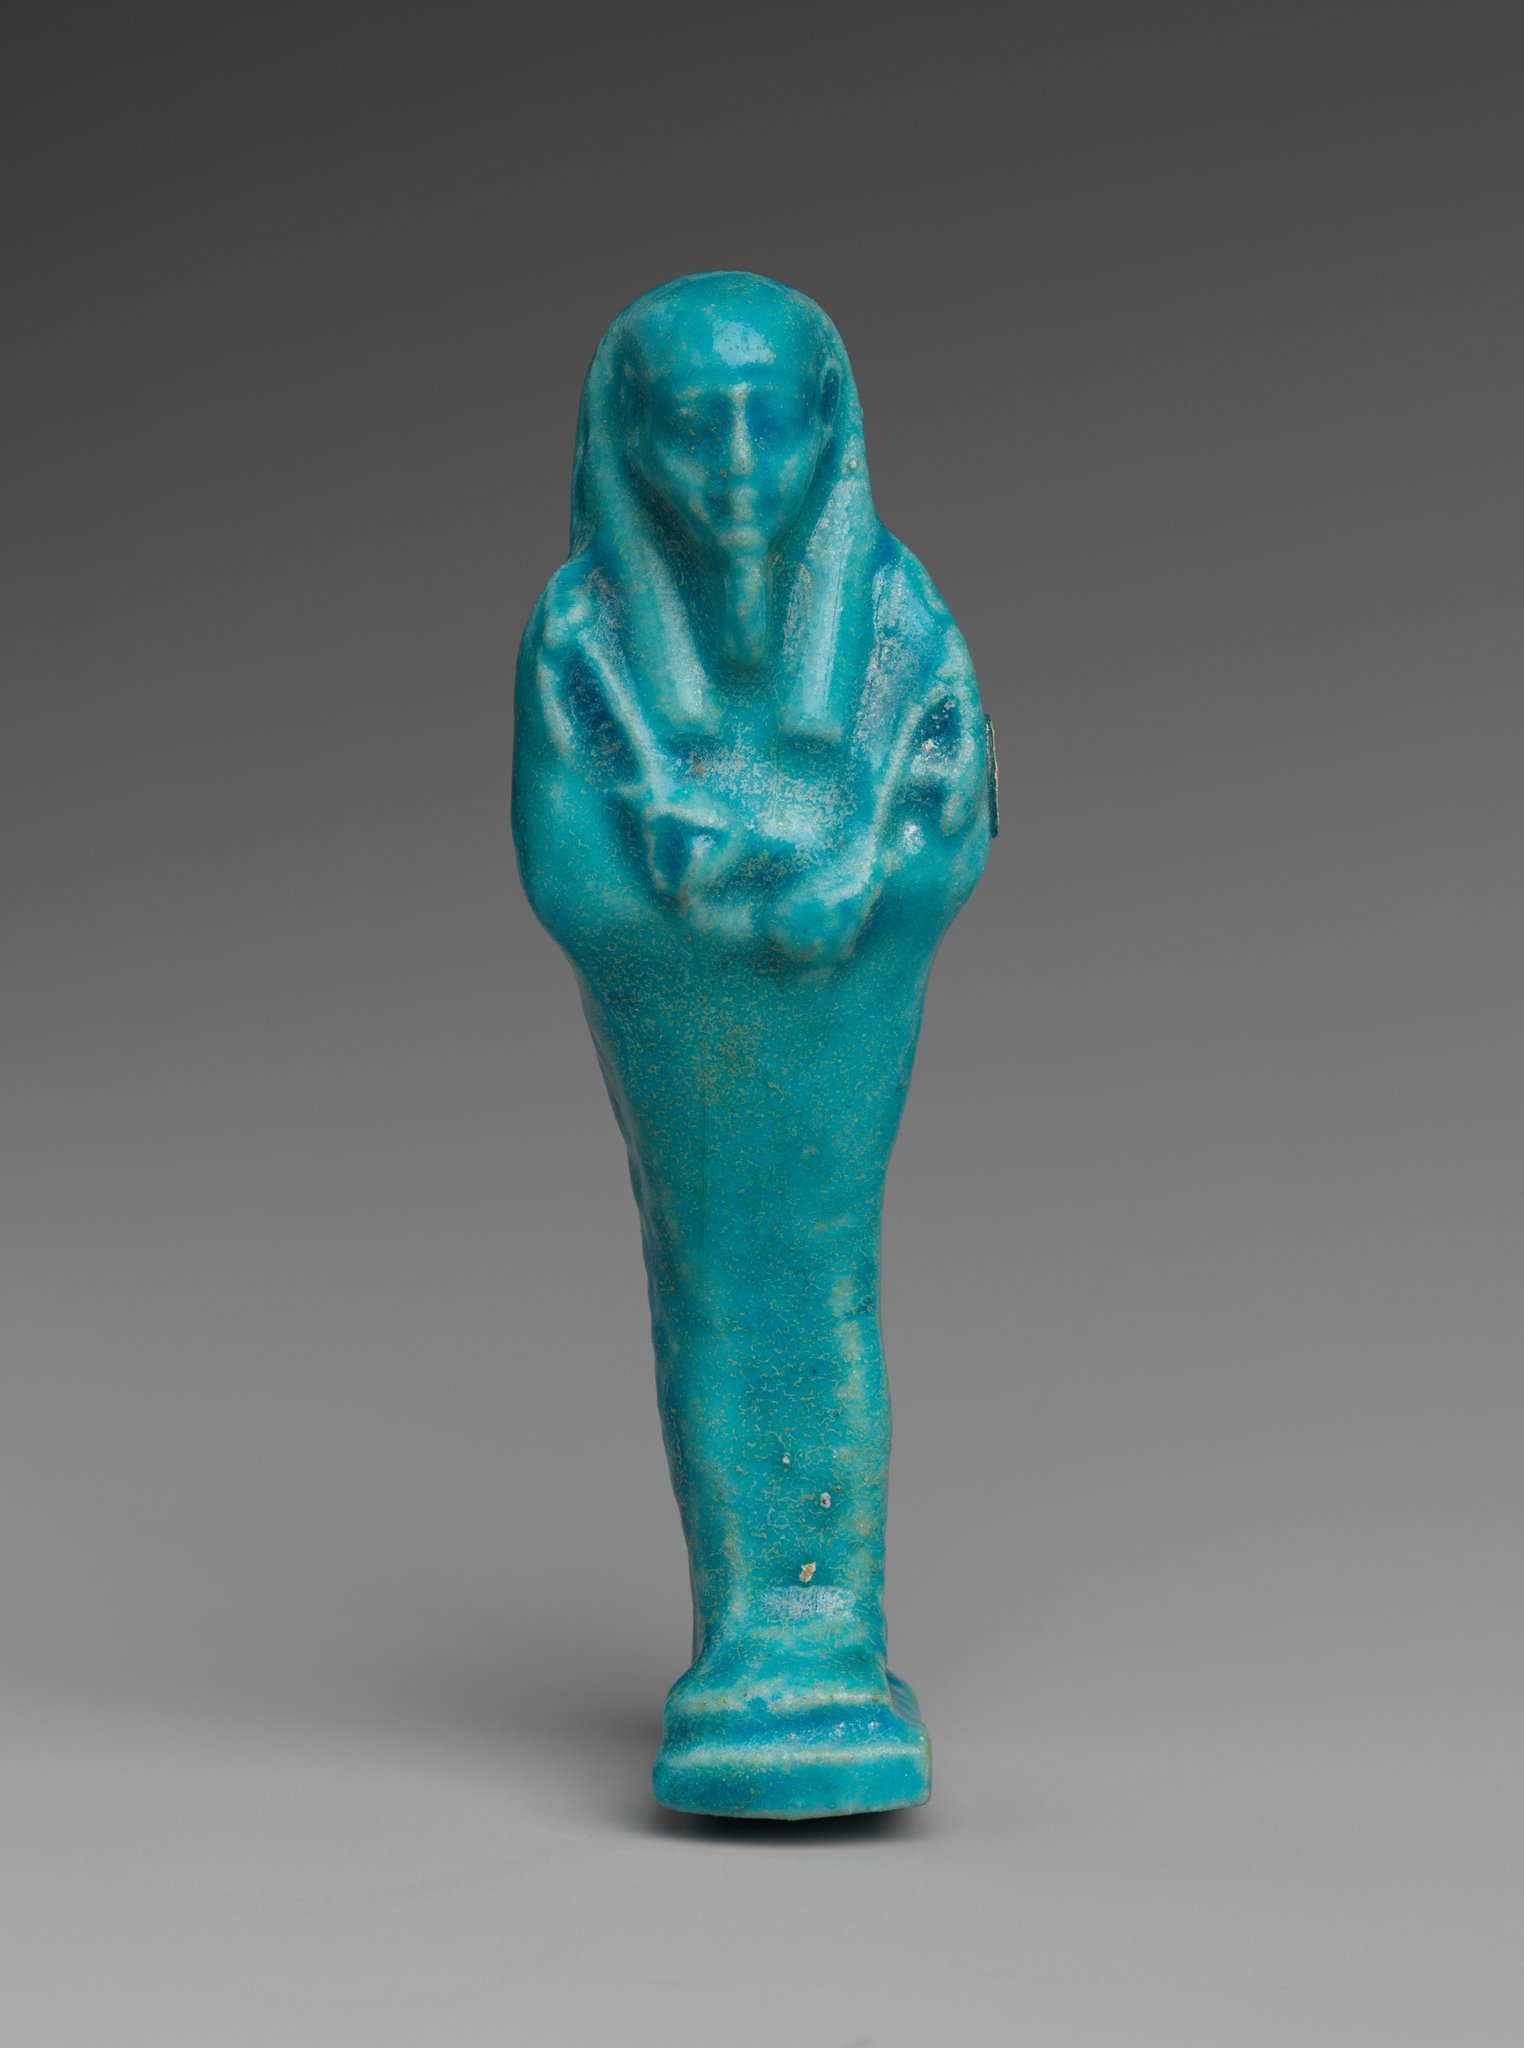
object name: shabti, peduasar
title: Shabti of Petosiris, son of Djedhor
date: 360-300 BCE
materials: faience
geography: egypt